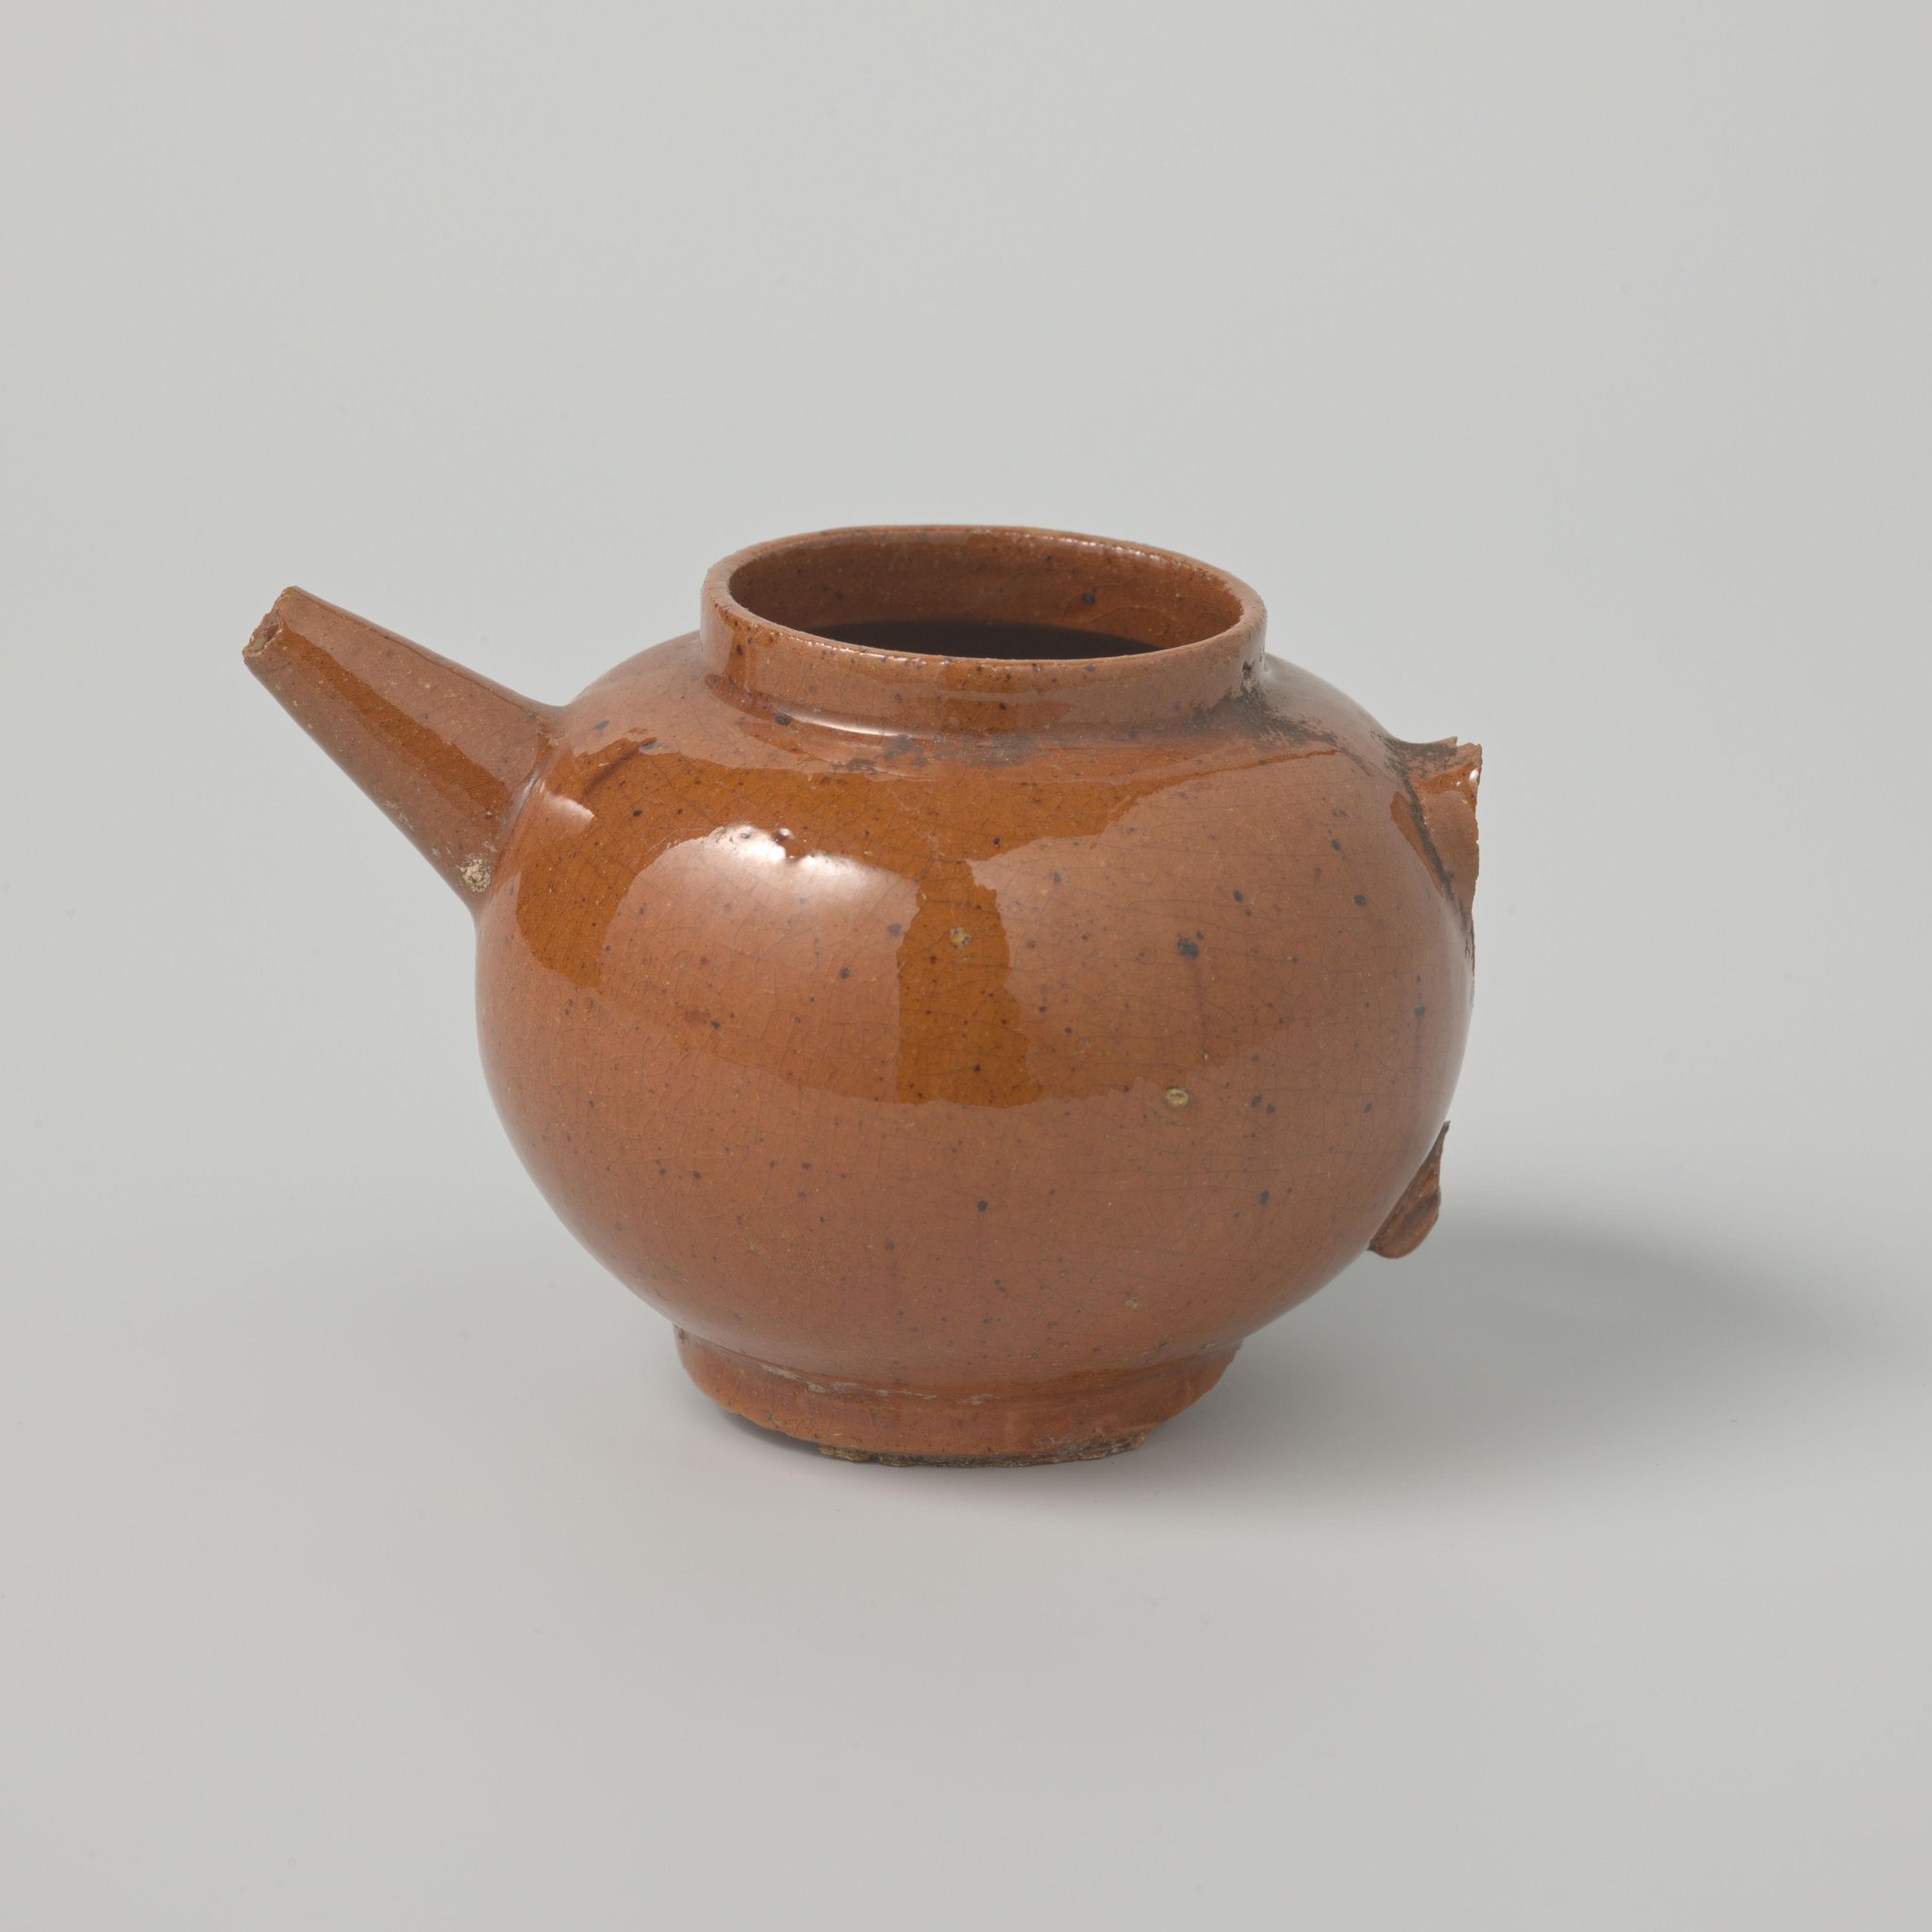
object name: bakafval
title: An Excavation Full of Teapots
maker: jacobus de caluwe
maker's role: plateelbakkerij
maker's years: -1730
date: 1700-1725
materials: earthenware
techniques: firing, vitrification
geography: delft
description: In the early 18th century, the Delft potter Jacobus de Caluwe experimented with innovative forms of teapots based on examples from Yixing. These teapots were excavated at the very site where De Caluwe had his factory. They exhibit a wide variety, ranging from traditional red stoneware items to new creations with glaze in different colours.